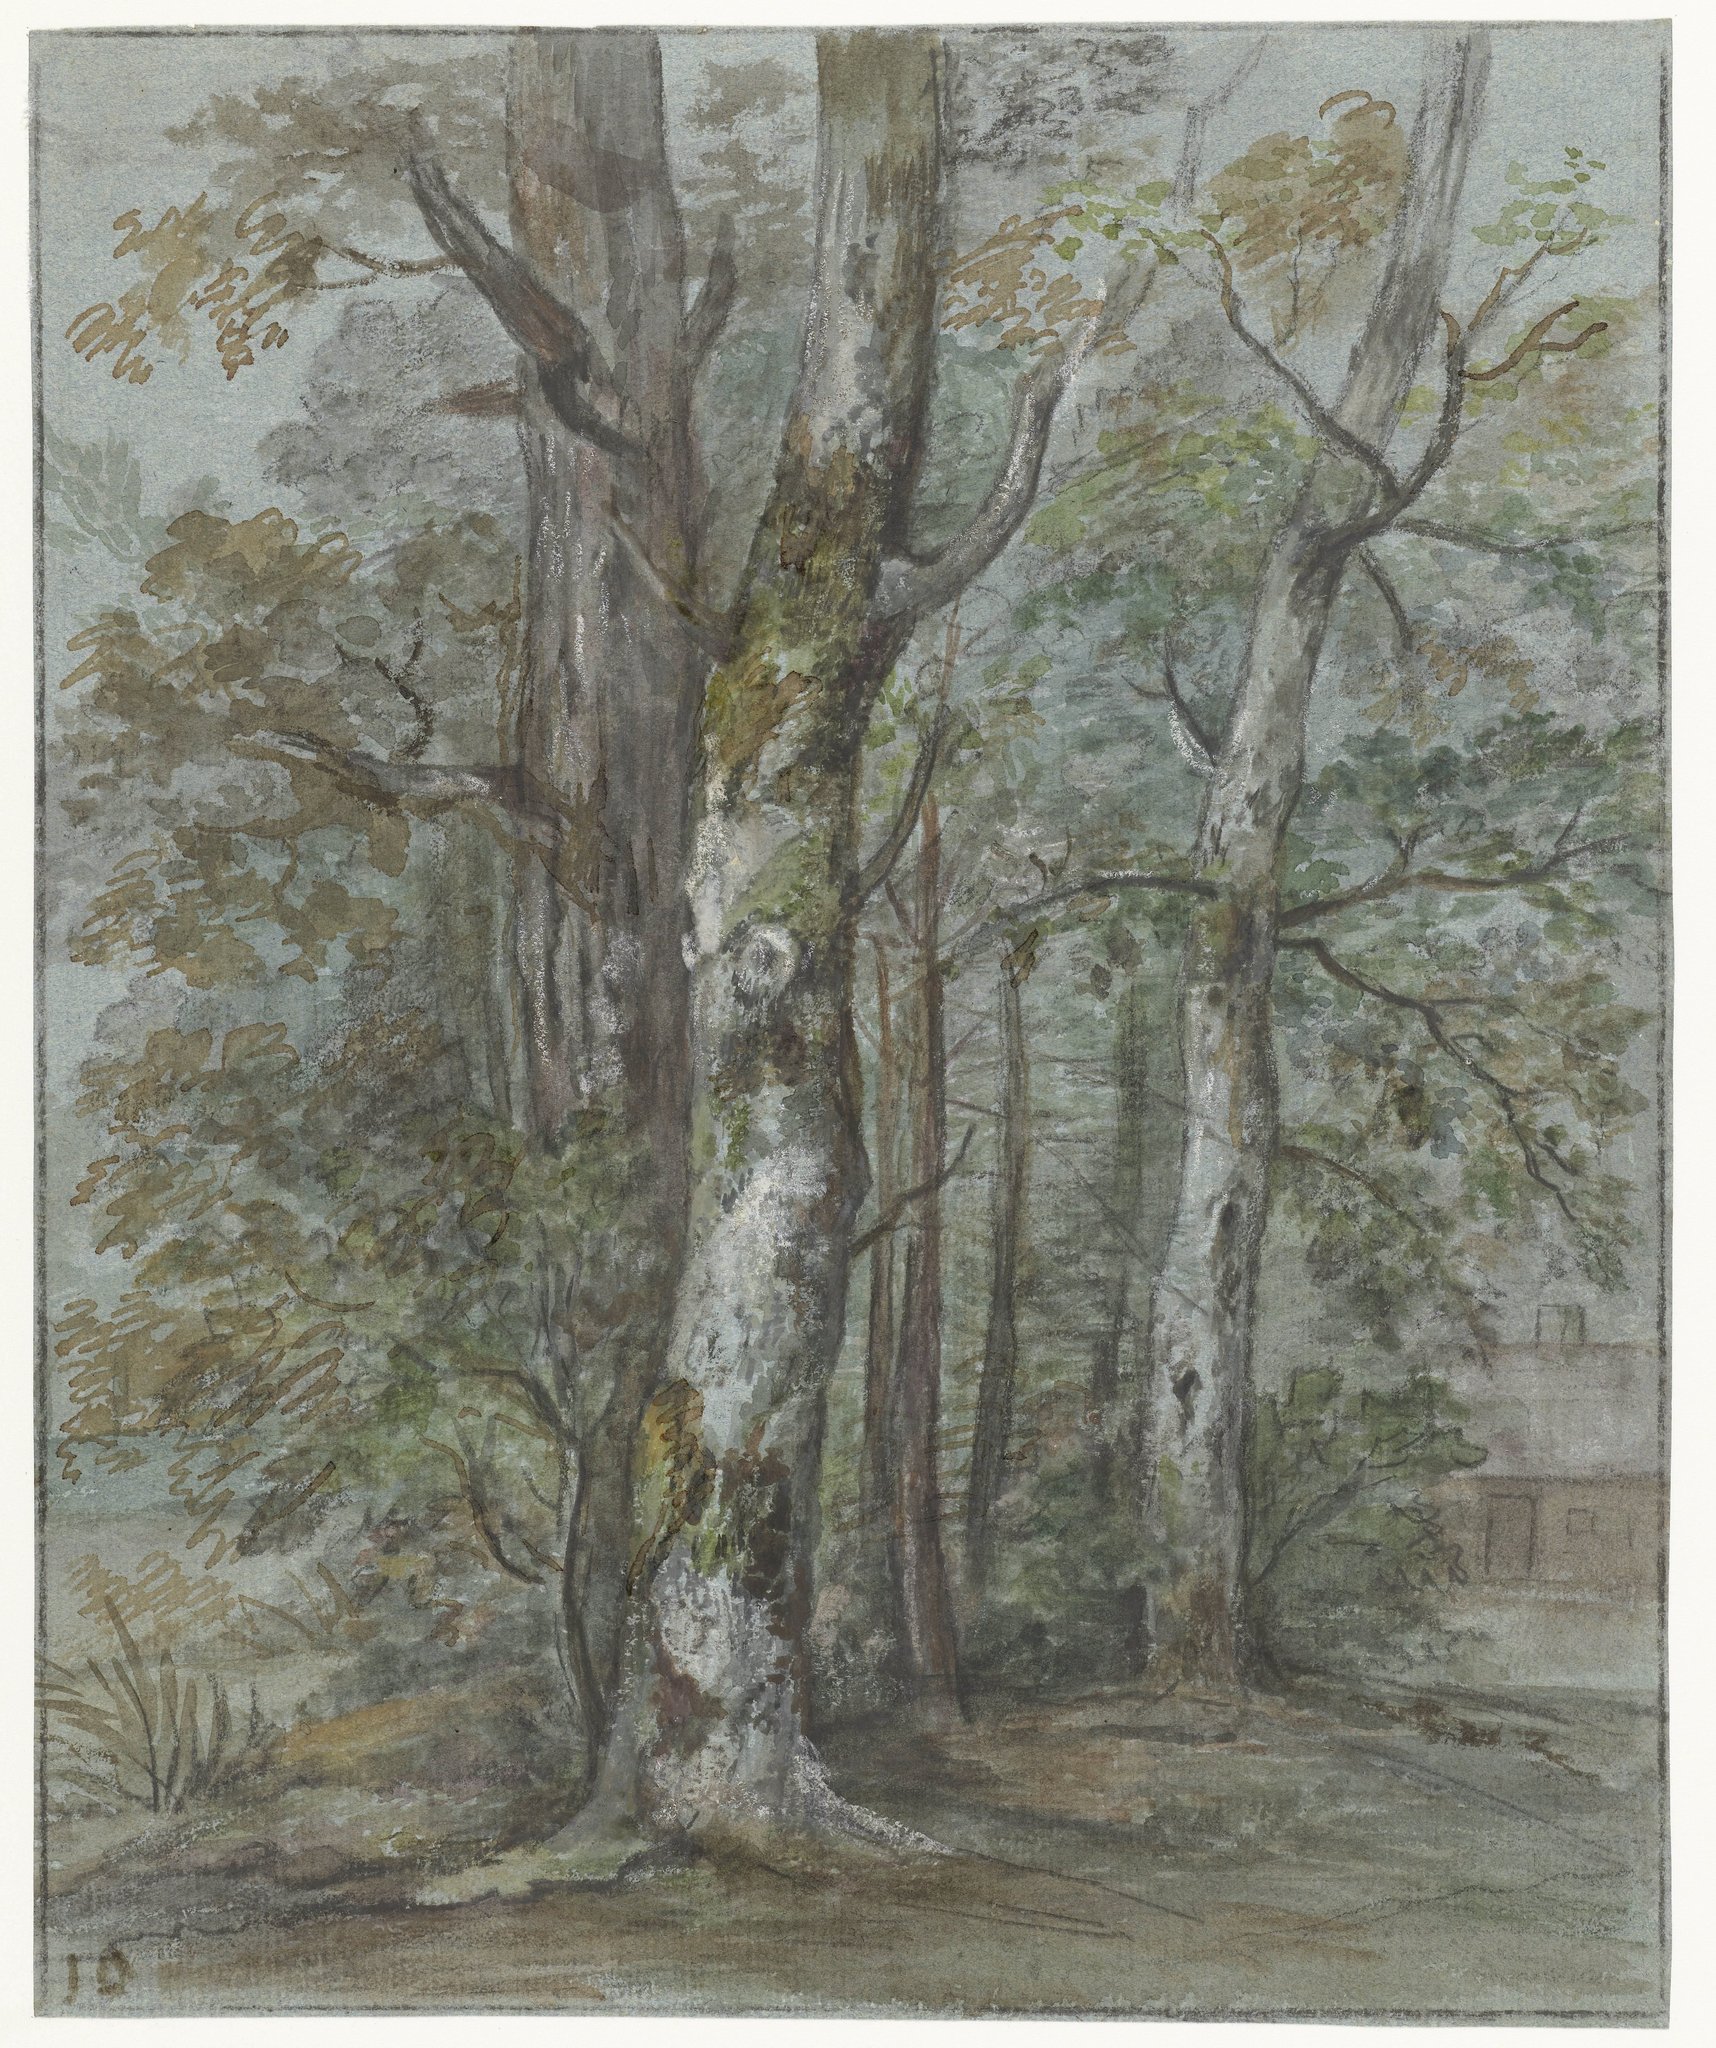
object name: drawing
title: Boomstudie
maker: jan dasveldt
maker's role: draughtsman, print maker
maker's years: 1770-1855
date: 1780-1855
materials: chalk, ink, paper, watercolor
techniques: brush, pen